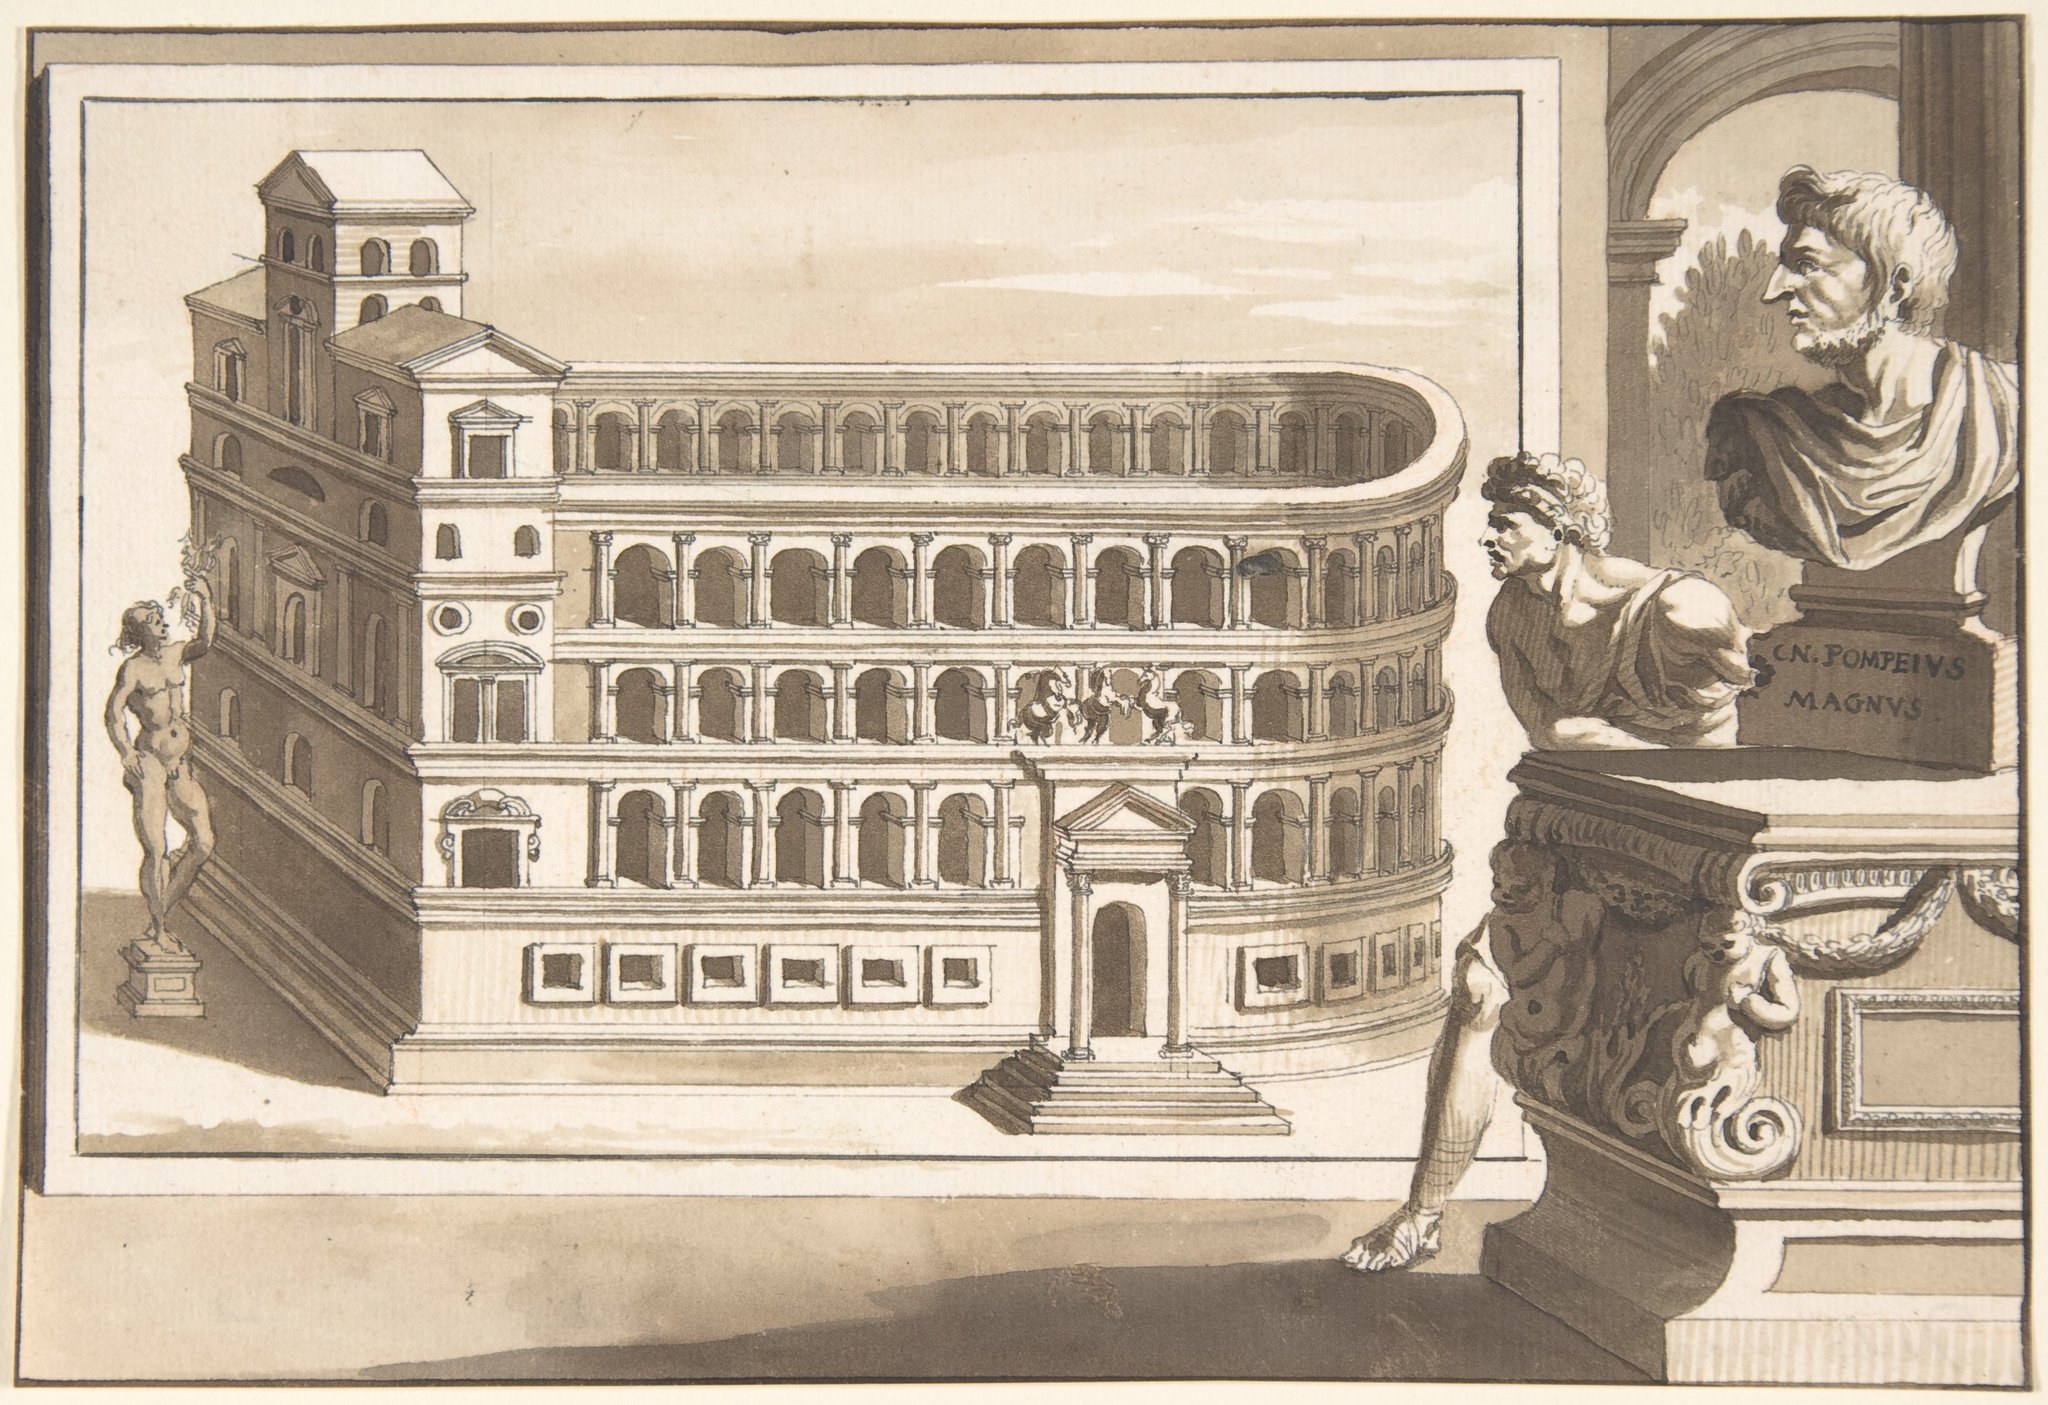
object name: drawing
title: A Reconstruction of the Theatre of Pompey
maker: jan goeree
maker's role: artist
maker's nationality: dutch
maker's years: 1670-1731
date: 1704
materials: chalk, ink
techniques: brush, pen, wash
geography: italy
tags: theatre,architecture